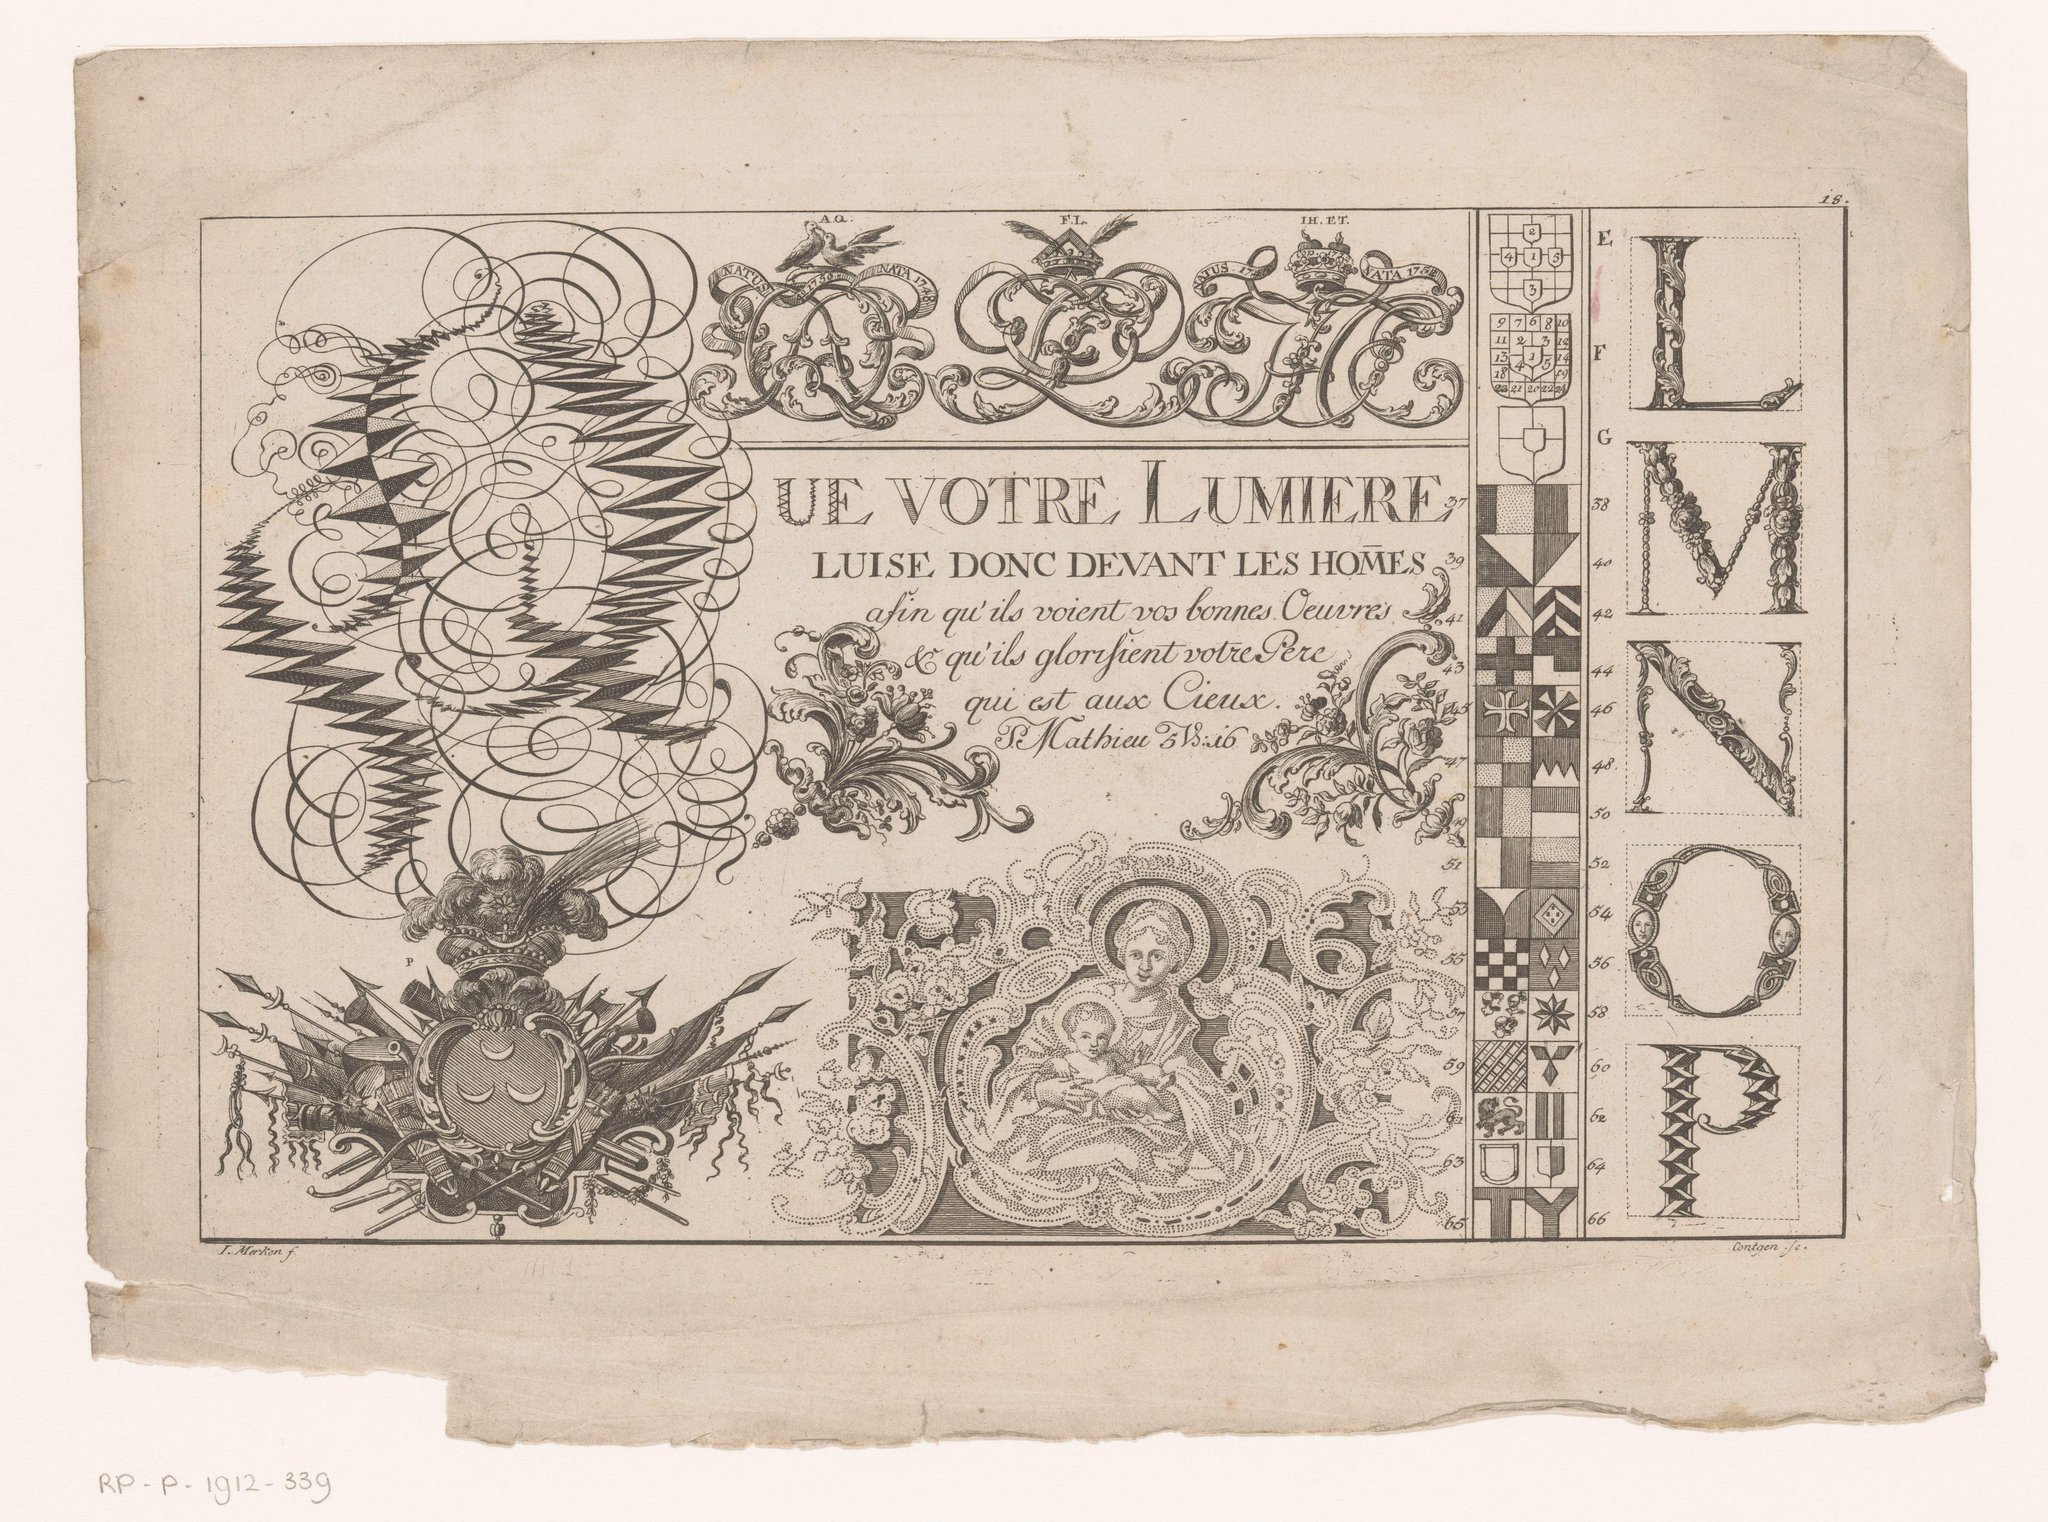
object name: ornament print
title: Ornamenten, kalligrafie en Madonna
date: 1782-1785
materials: paper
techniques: engraving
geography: elberfeld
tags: ornaments ~ art, madonna: i.e. mary with the christ-child, calligraphy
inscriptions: watermark, collector's mark: Lugt 2228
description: Prent achttien uit: Merken, Johann. Liber Artificiosvs Alphabeti Maioris, oder: neu inventirtes Kunst- Schreib- und Zeichenbuch: bestehend in 56 künstlich gravirten Kupferstichen, nebst beigefügter Abhandlung der darinn enthaltenen nützlichen und angenehmen Wissenschaften (...). Mülheim am Rhein: Eyrich, Johann Conrad, 1782-1785.